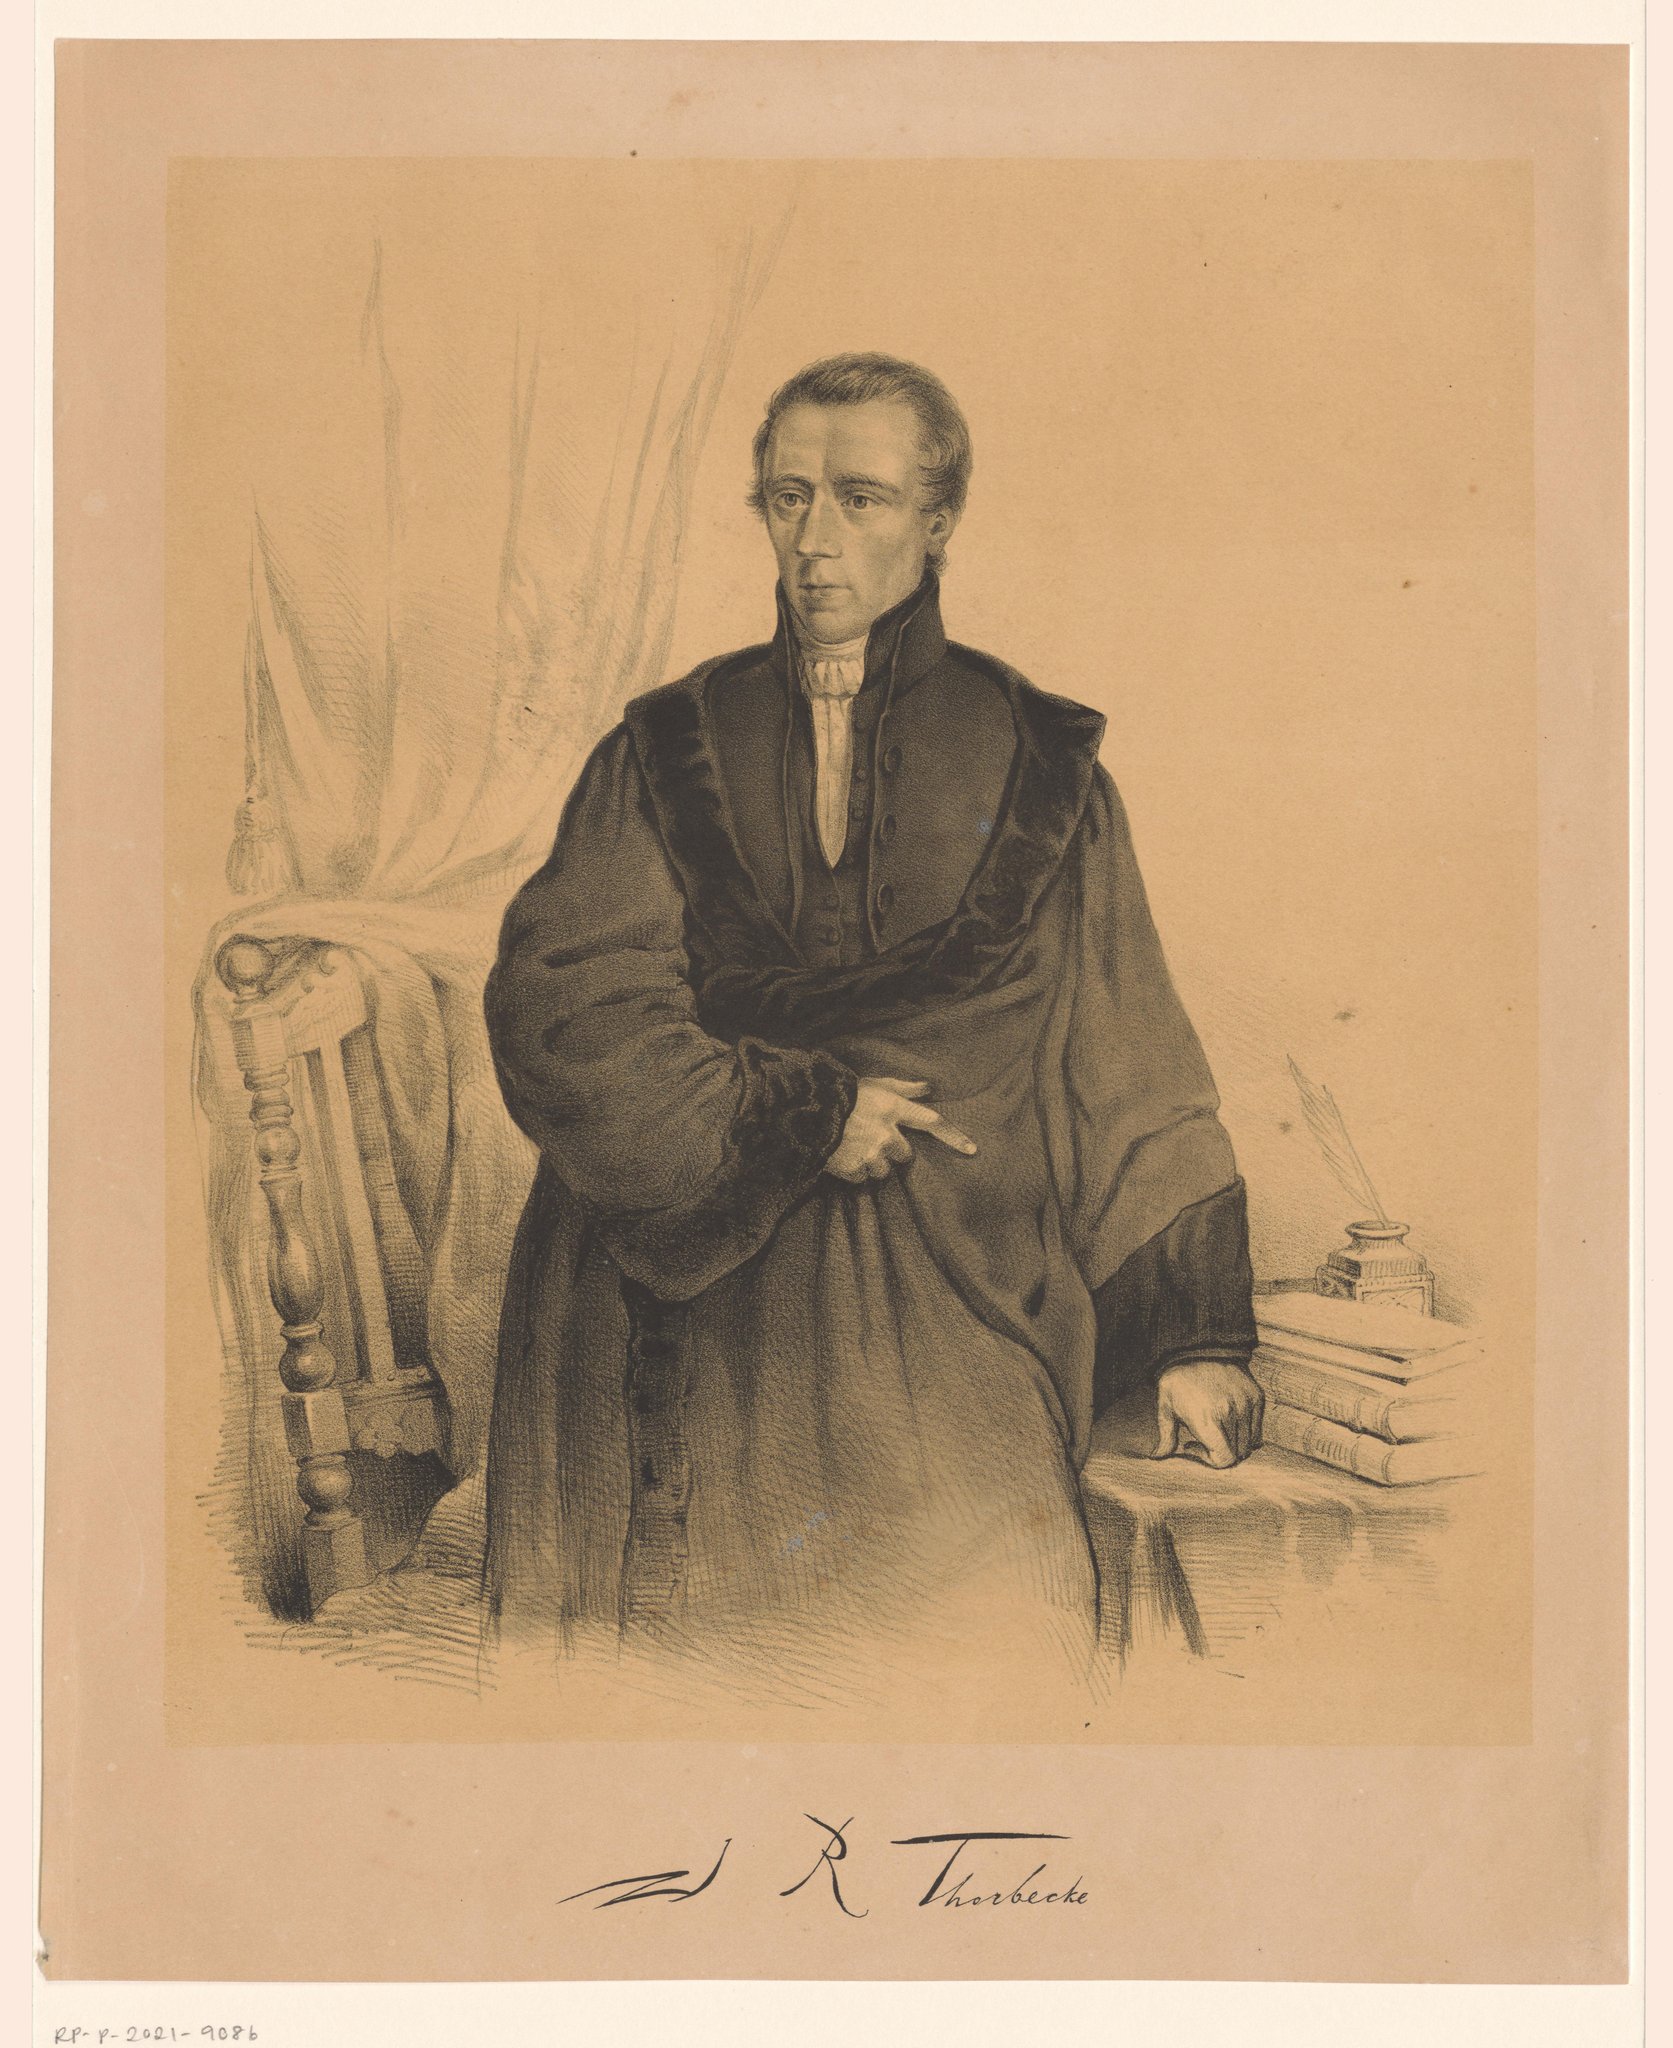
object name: print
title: Portret van Johan Rudolf Thorbecke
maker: Anonymous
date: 1840-1880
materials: paper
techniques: tone lithography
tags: johan rudolf thorbecke, historical persons, book, politician, e.g. party leader